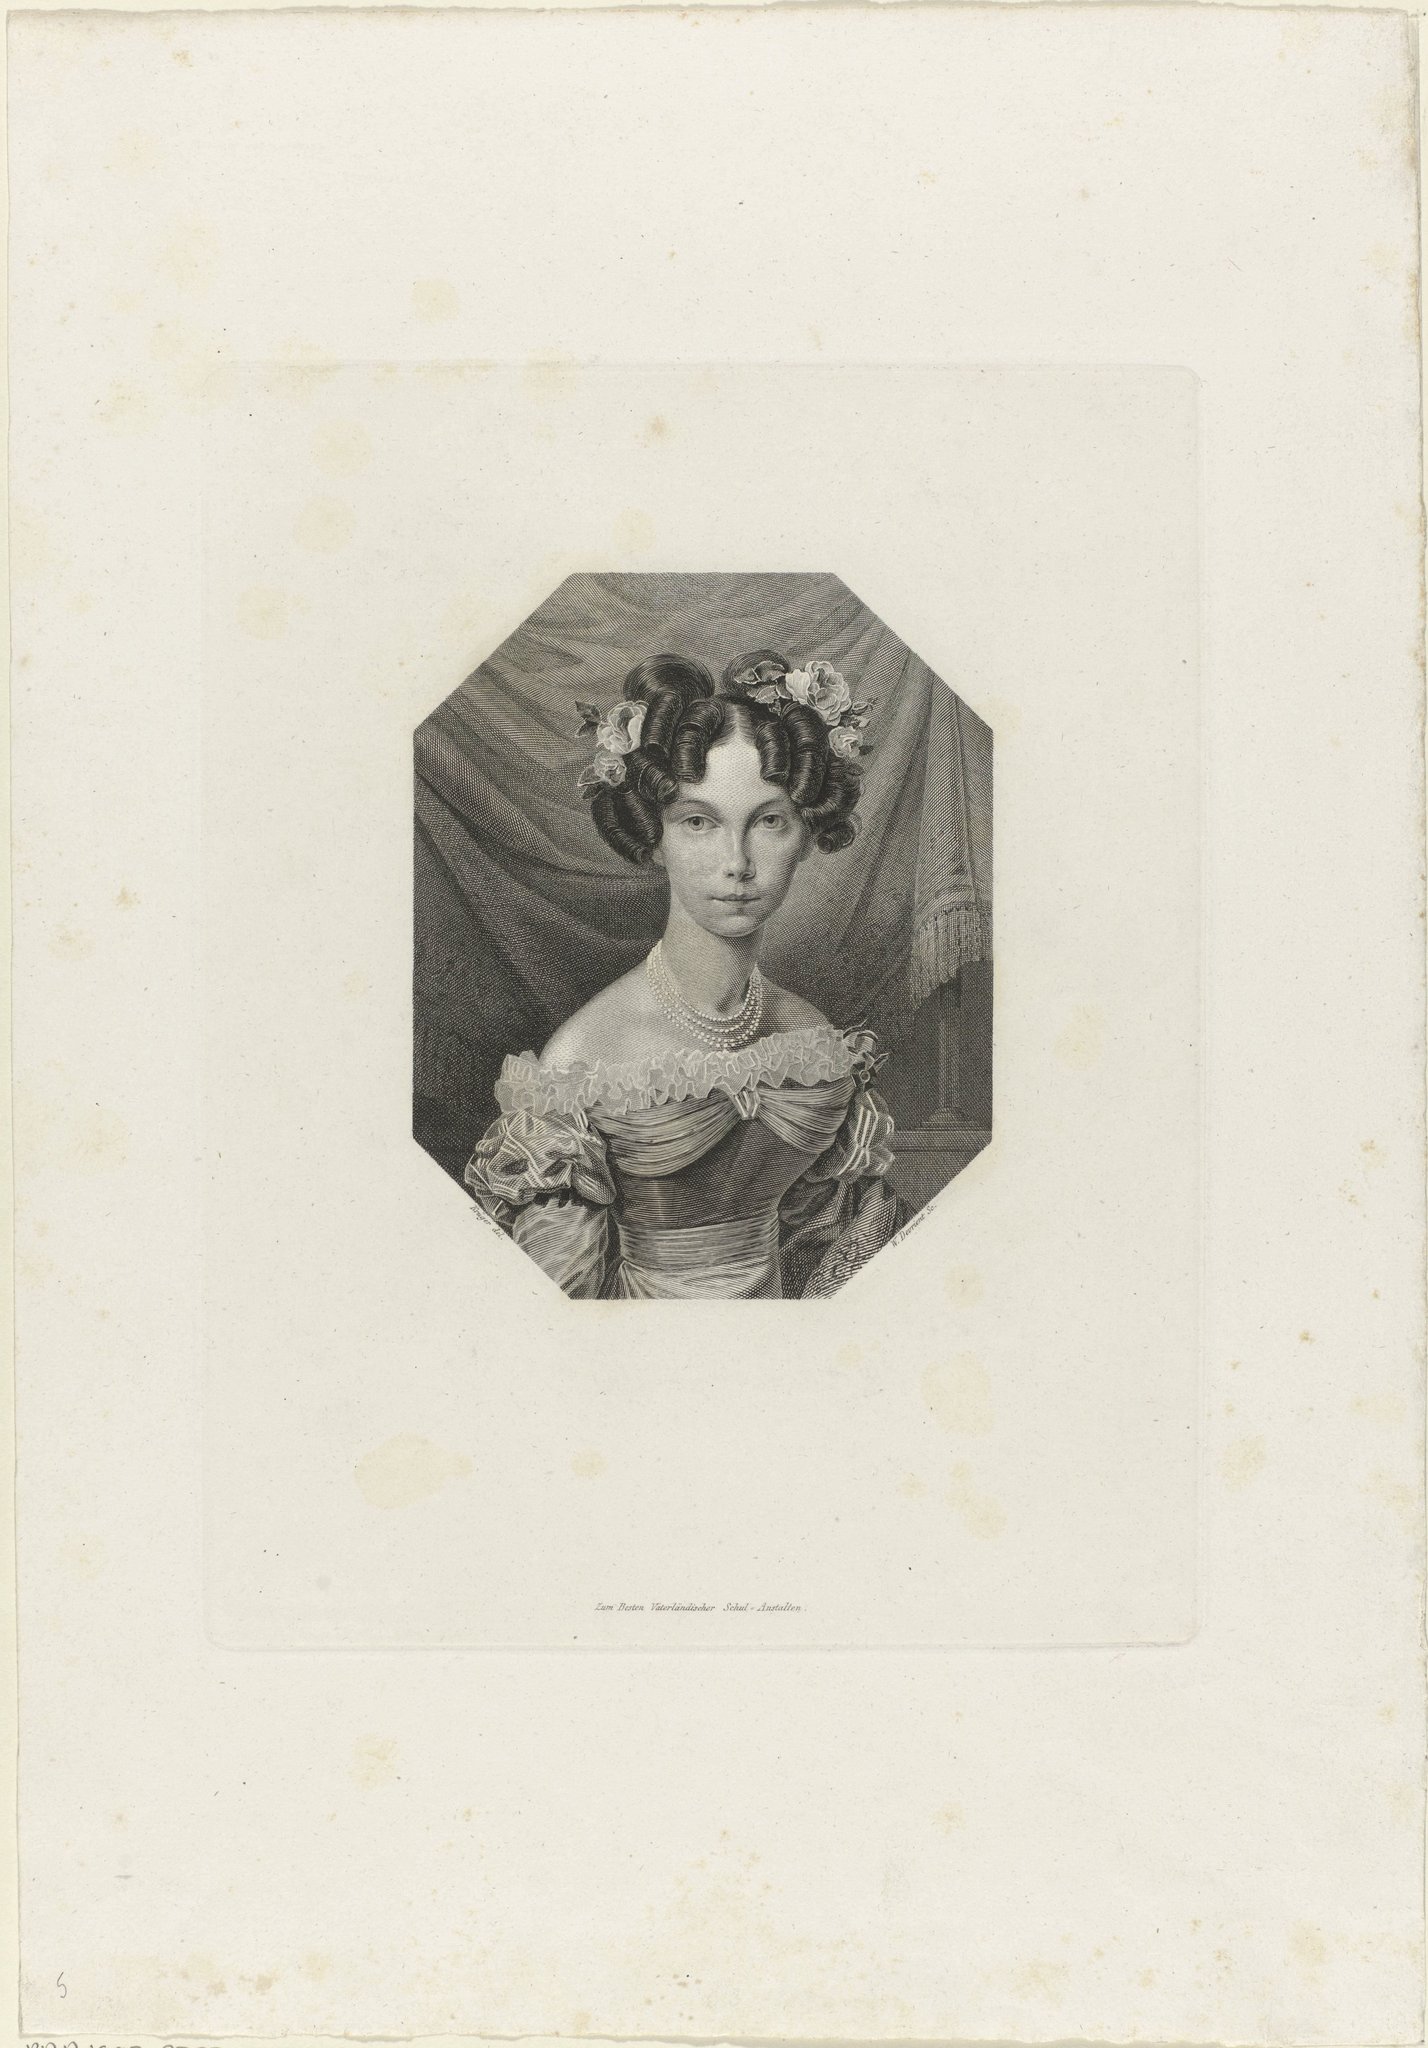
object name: print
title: Portret van Louise van Pruisen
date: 1825-1899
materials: paper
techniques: engraving, etching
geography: berlin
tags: koningsbergen, wassenaar, prinses, louise van pruisen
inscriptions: collector's mark: Lugt 2228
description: Portret van Louise in een achtkantige omlijsting. In de ondermarge een regel Duitse tekst.